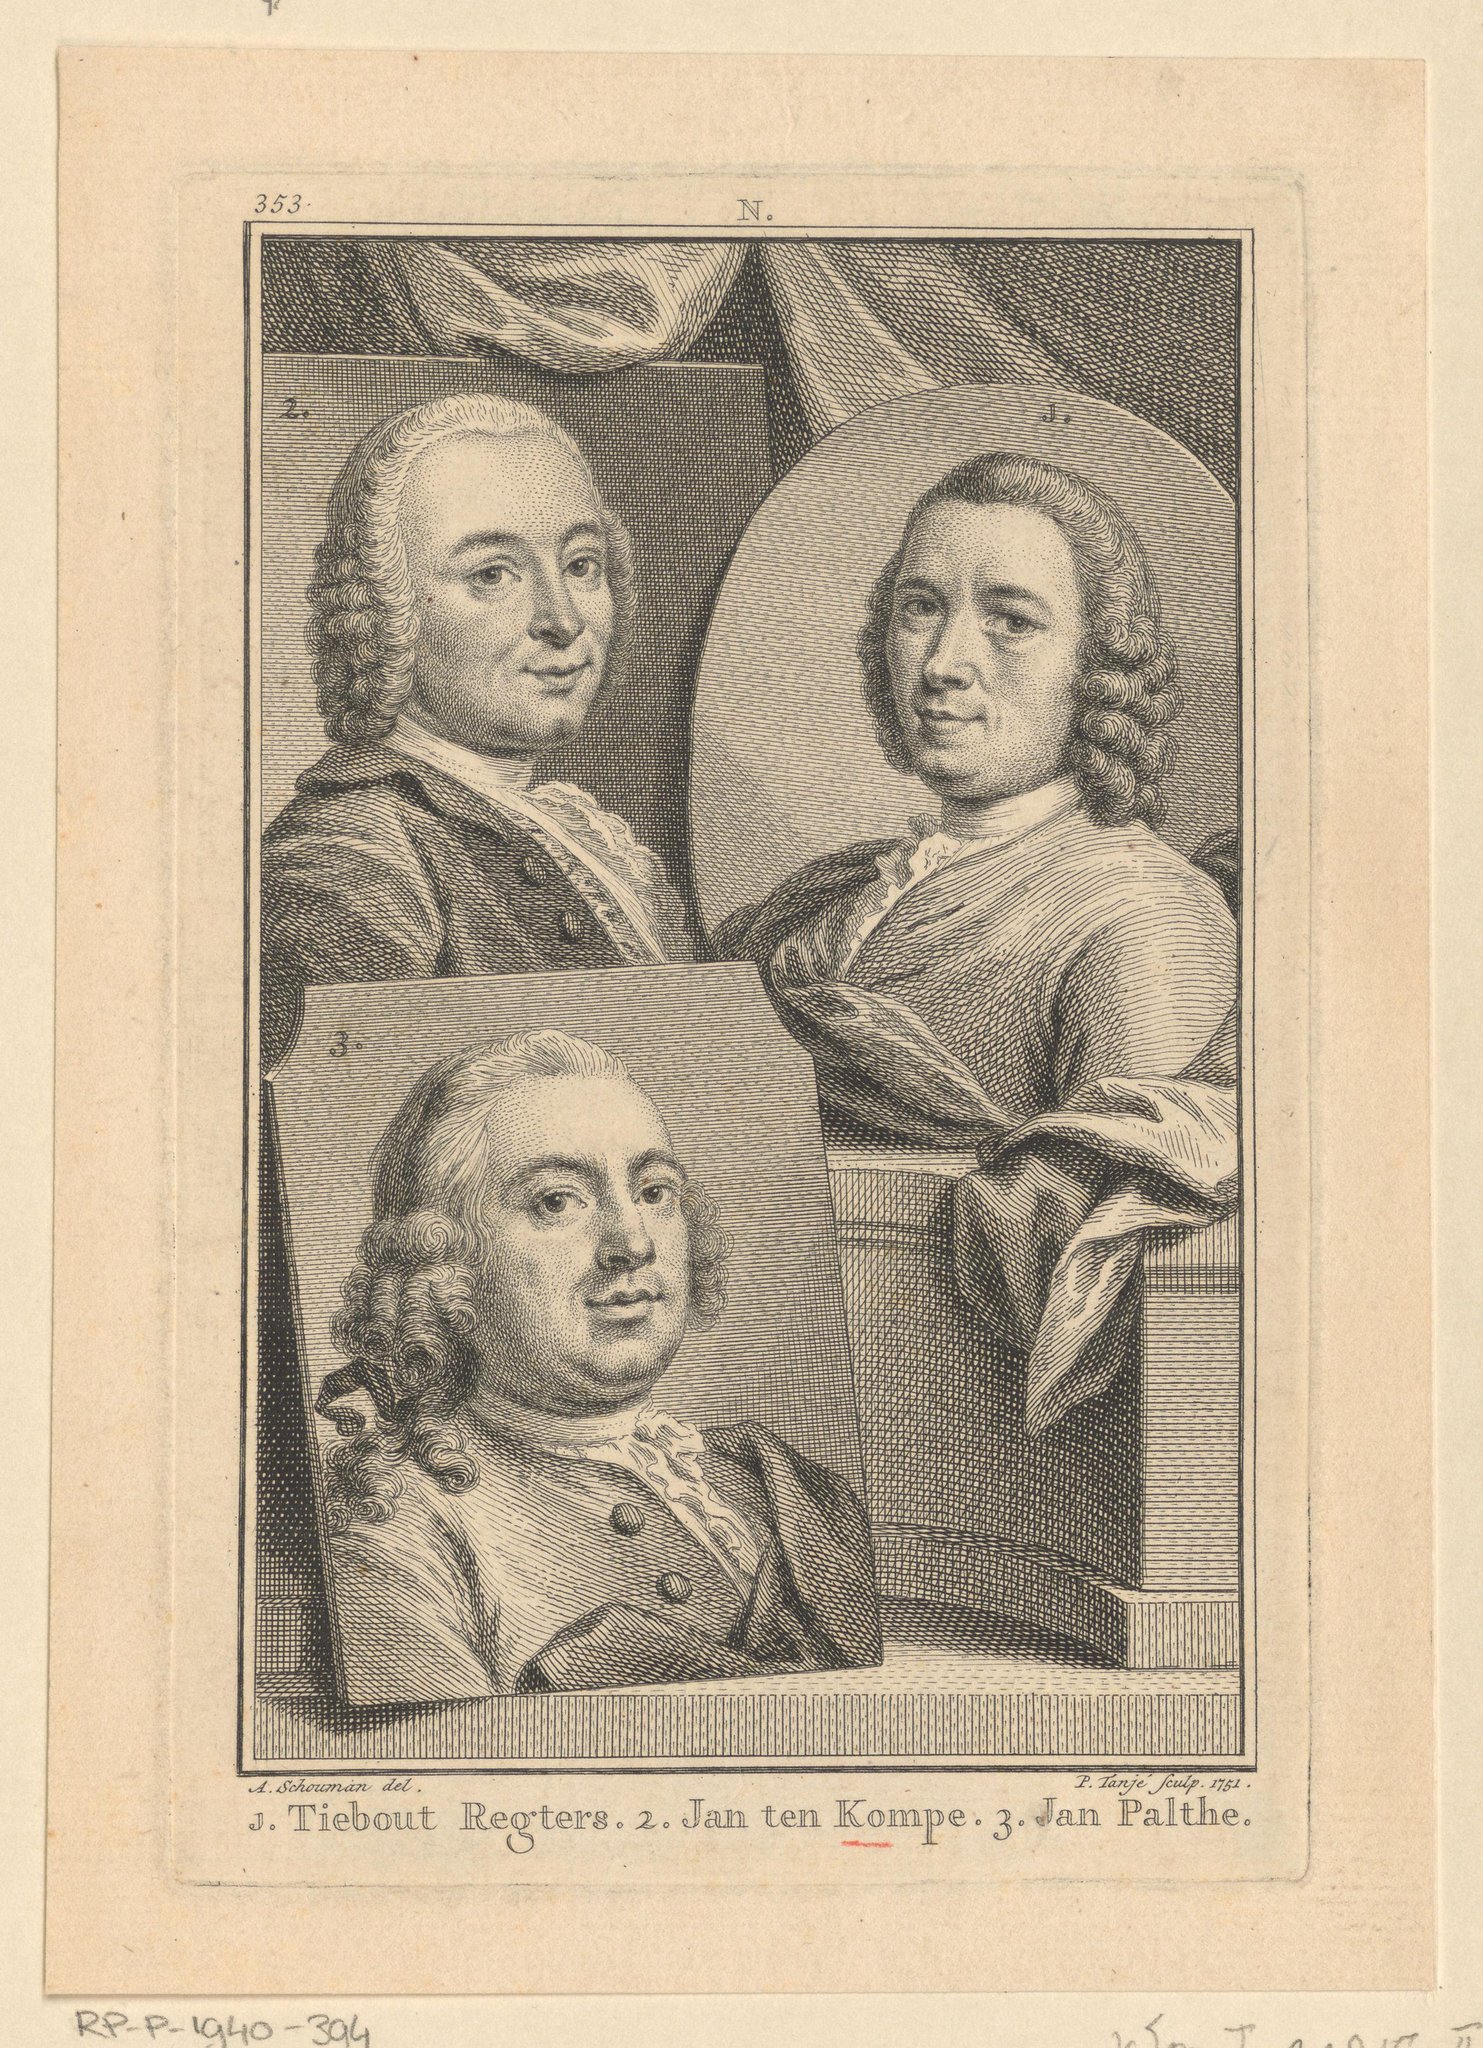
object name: print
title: Portretten van Tiebout Regters, Jan ten Compe en Jan Palthe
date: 1751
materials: paper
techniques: engraving, etching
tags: deventer, leiden, jan palthe, dordrecht, amsterdam, painter, draughtsman, tibout regters, jan ten compe, historical persons, portrait, self-portrait of painter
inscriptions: collector's mark: Lugt 2228, collector's mark: Lugt 2760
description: Prent waarschijnlijk uit: Gool, Johan van. De nieuwe schouburg der Nederlantsche kunstschilders en schilderessen. Den Haag: Johan van Gool, 1751, dl. 2, p. 353.